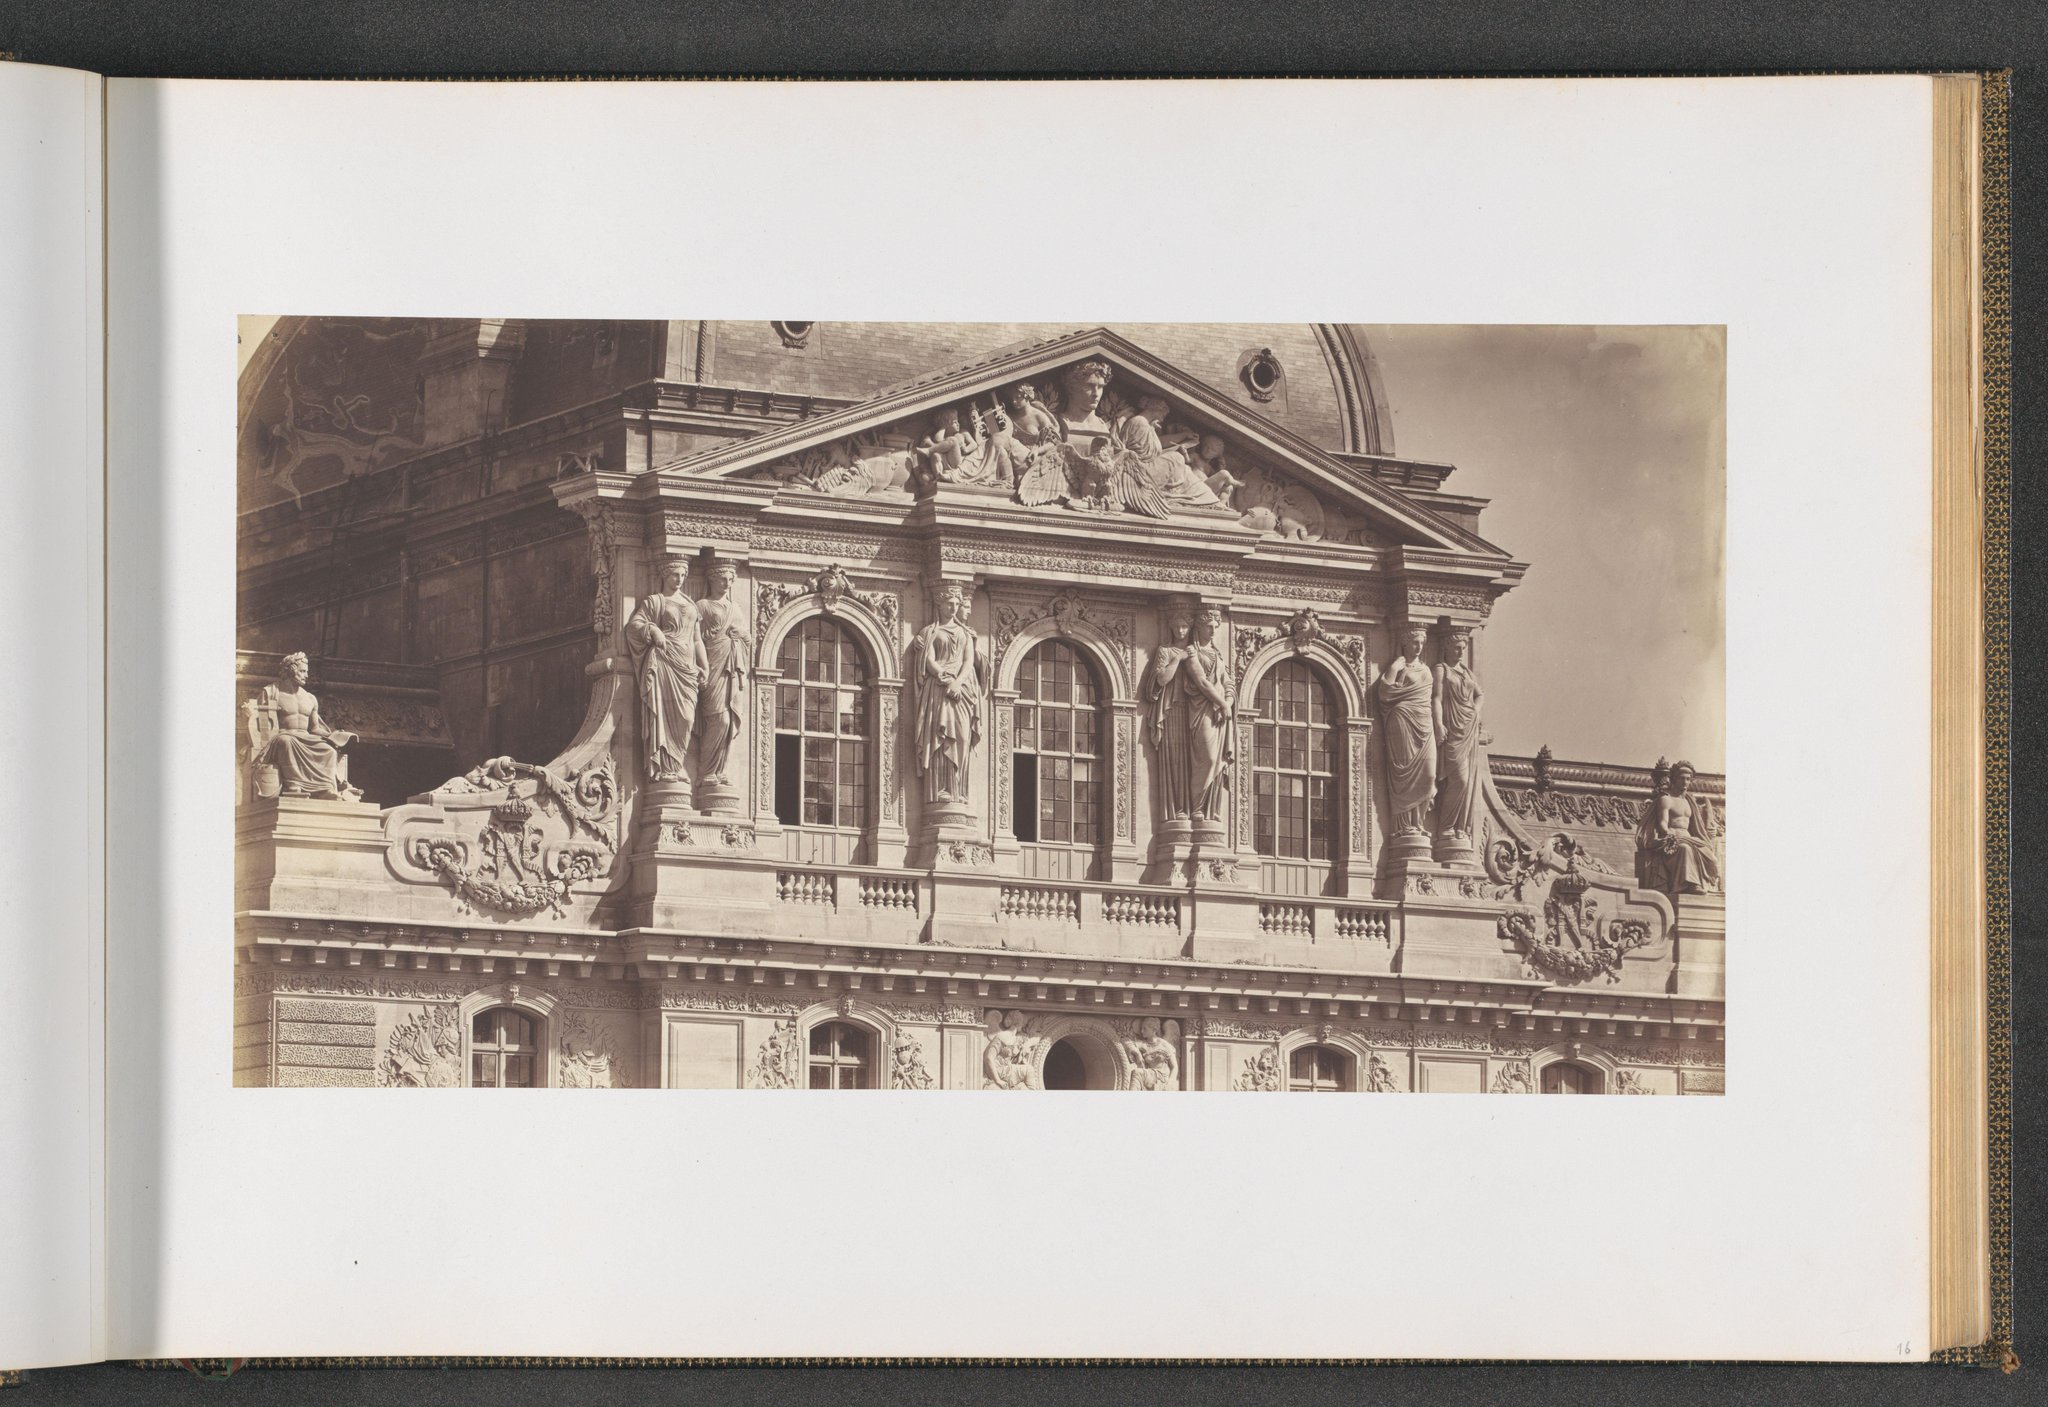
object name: album leaf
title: Derde verdieping van het Pavillon Sully in het Palais du Louvre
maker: édouard denis baldus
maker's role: fotograaf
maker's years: 1813-1889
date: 1857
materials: paper, photographic support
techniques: salted paper print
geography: paris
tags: caryatids ~ architecture, other architectural details (with name), permanent exhibition, museum, façade (of house or building), paris, tuileries palace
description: Onderdeel van Réunion des Tuileries au Louvre 1852-1857, album 2.